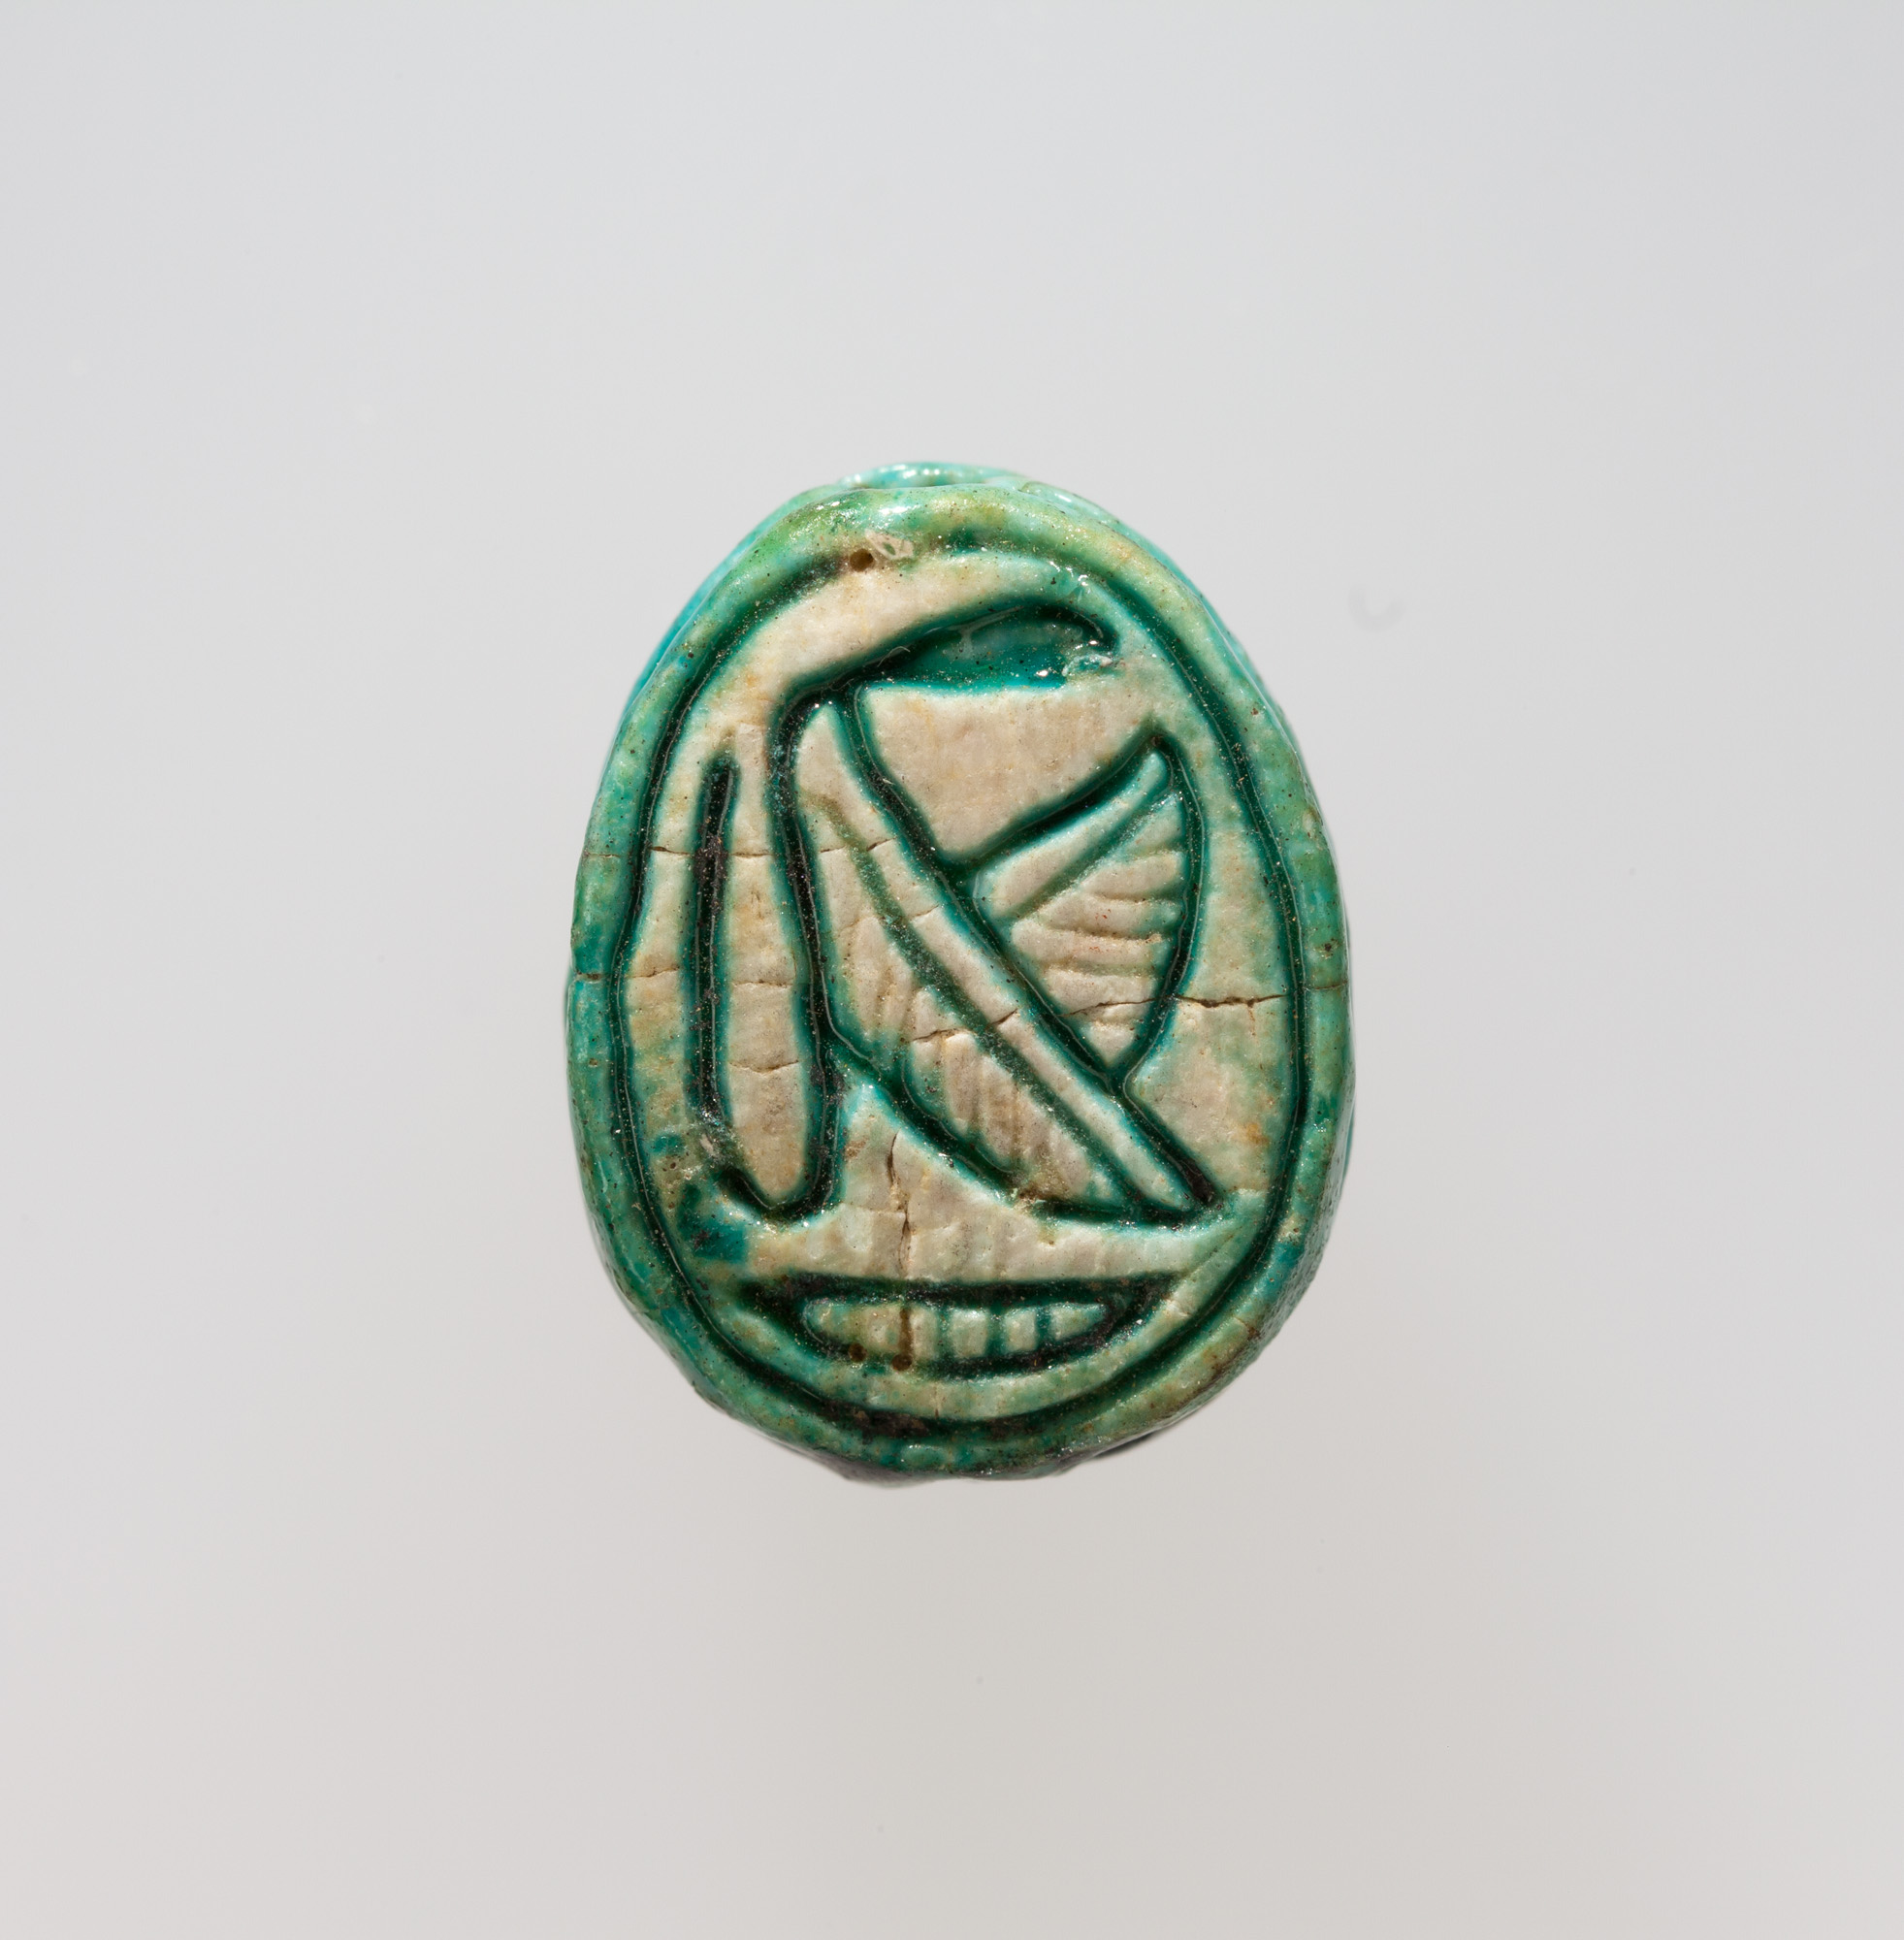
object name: scarab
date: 1479-1458 BCE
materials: faience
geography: egypt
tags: scarabs